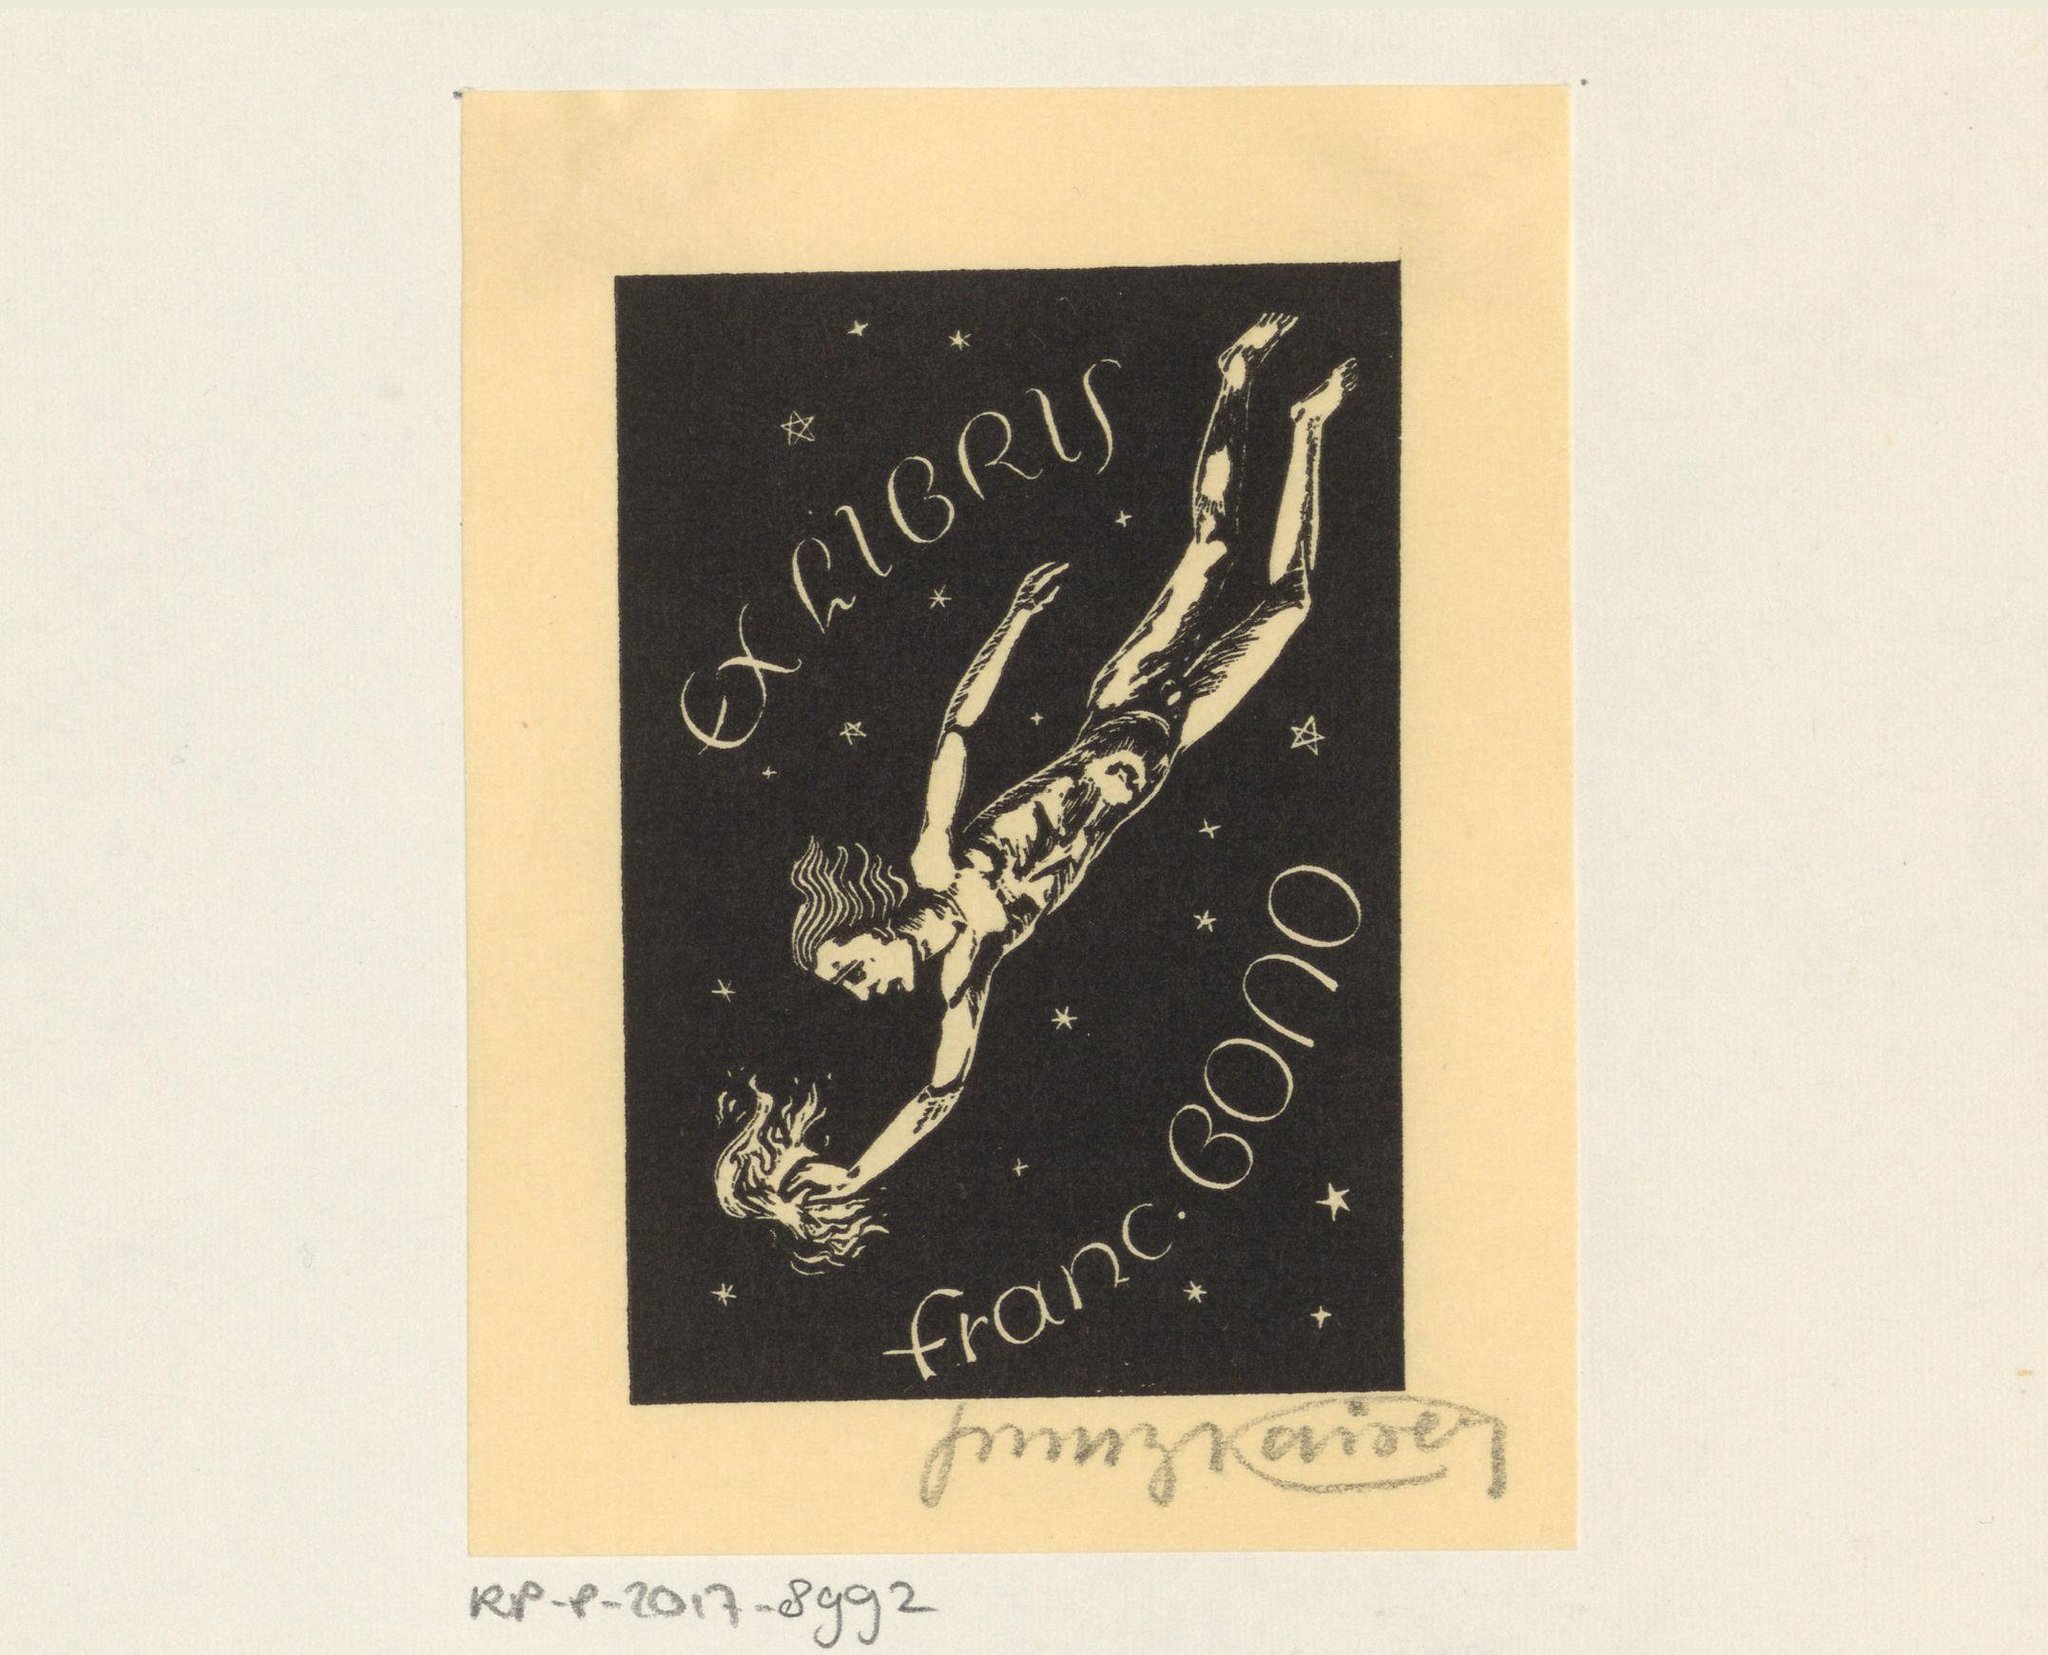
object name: bookplate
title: Ex libris Franc. Bono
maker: franz kaiser (prentmaker)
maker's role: print maker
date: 1900-1999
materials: paper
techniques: woodcut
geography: austria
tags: falling, stars, man (showing himself) undressed, quasi-nude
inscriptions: signature: ‘Franz Kaiser’